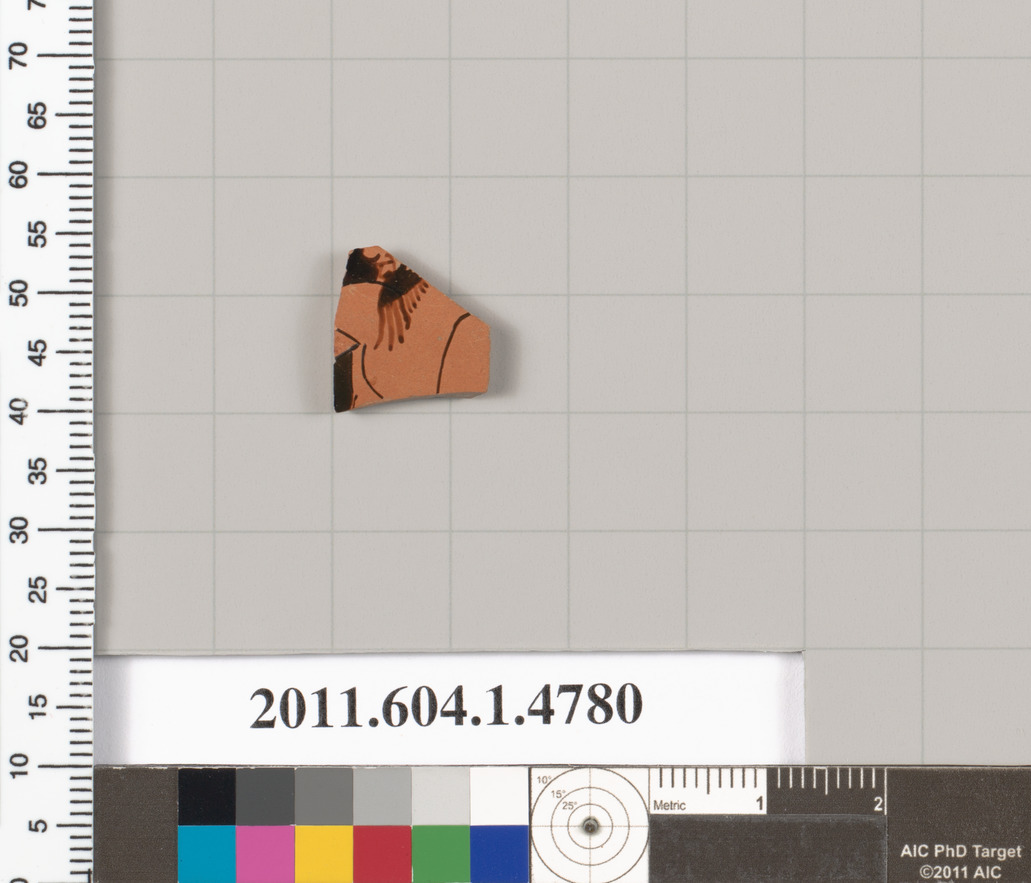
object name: kylix fragment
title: Terracotta fragment of a kylix (drinking cup)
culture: greek, attic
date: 500-480 BCE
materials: terracotta